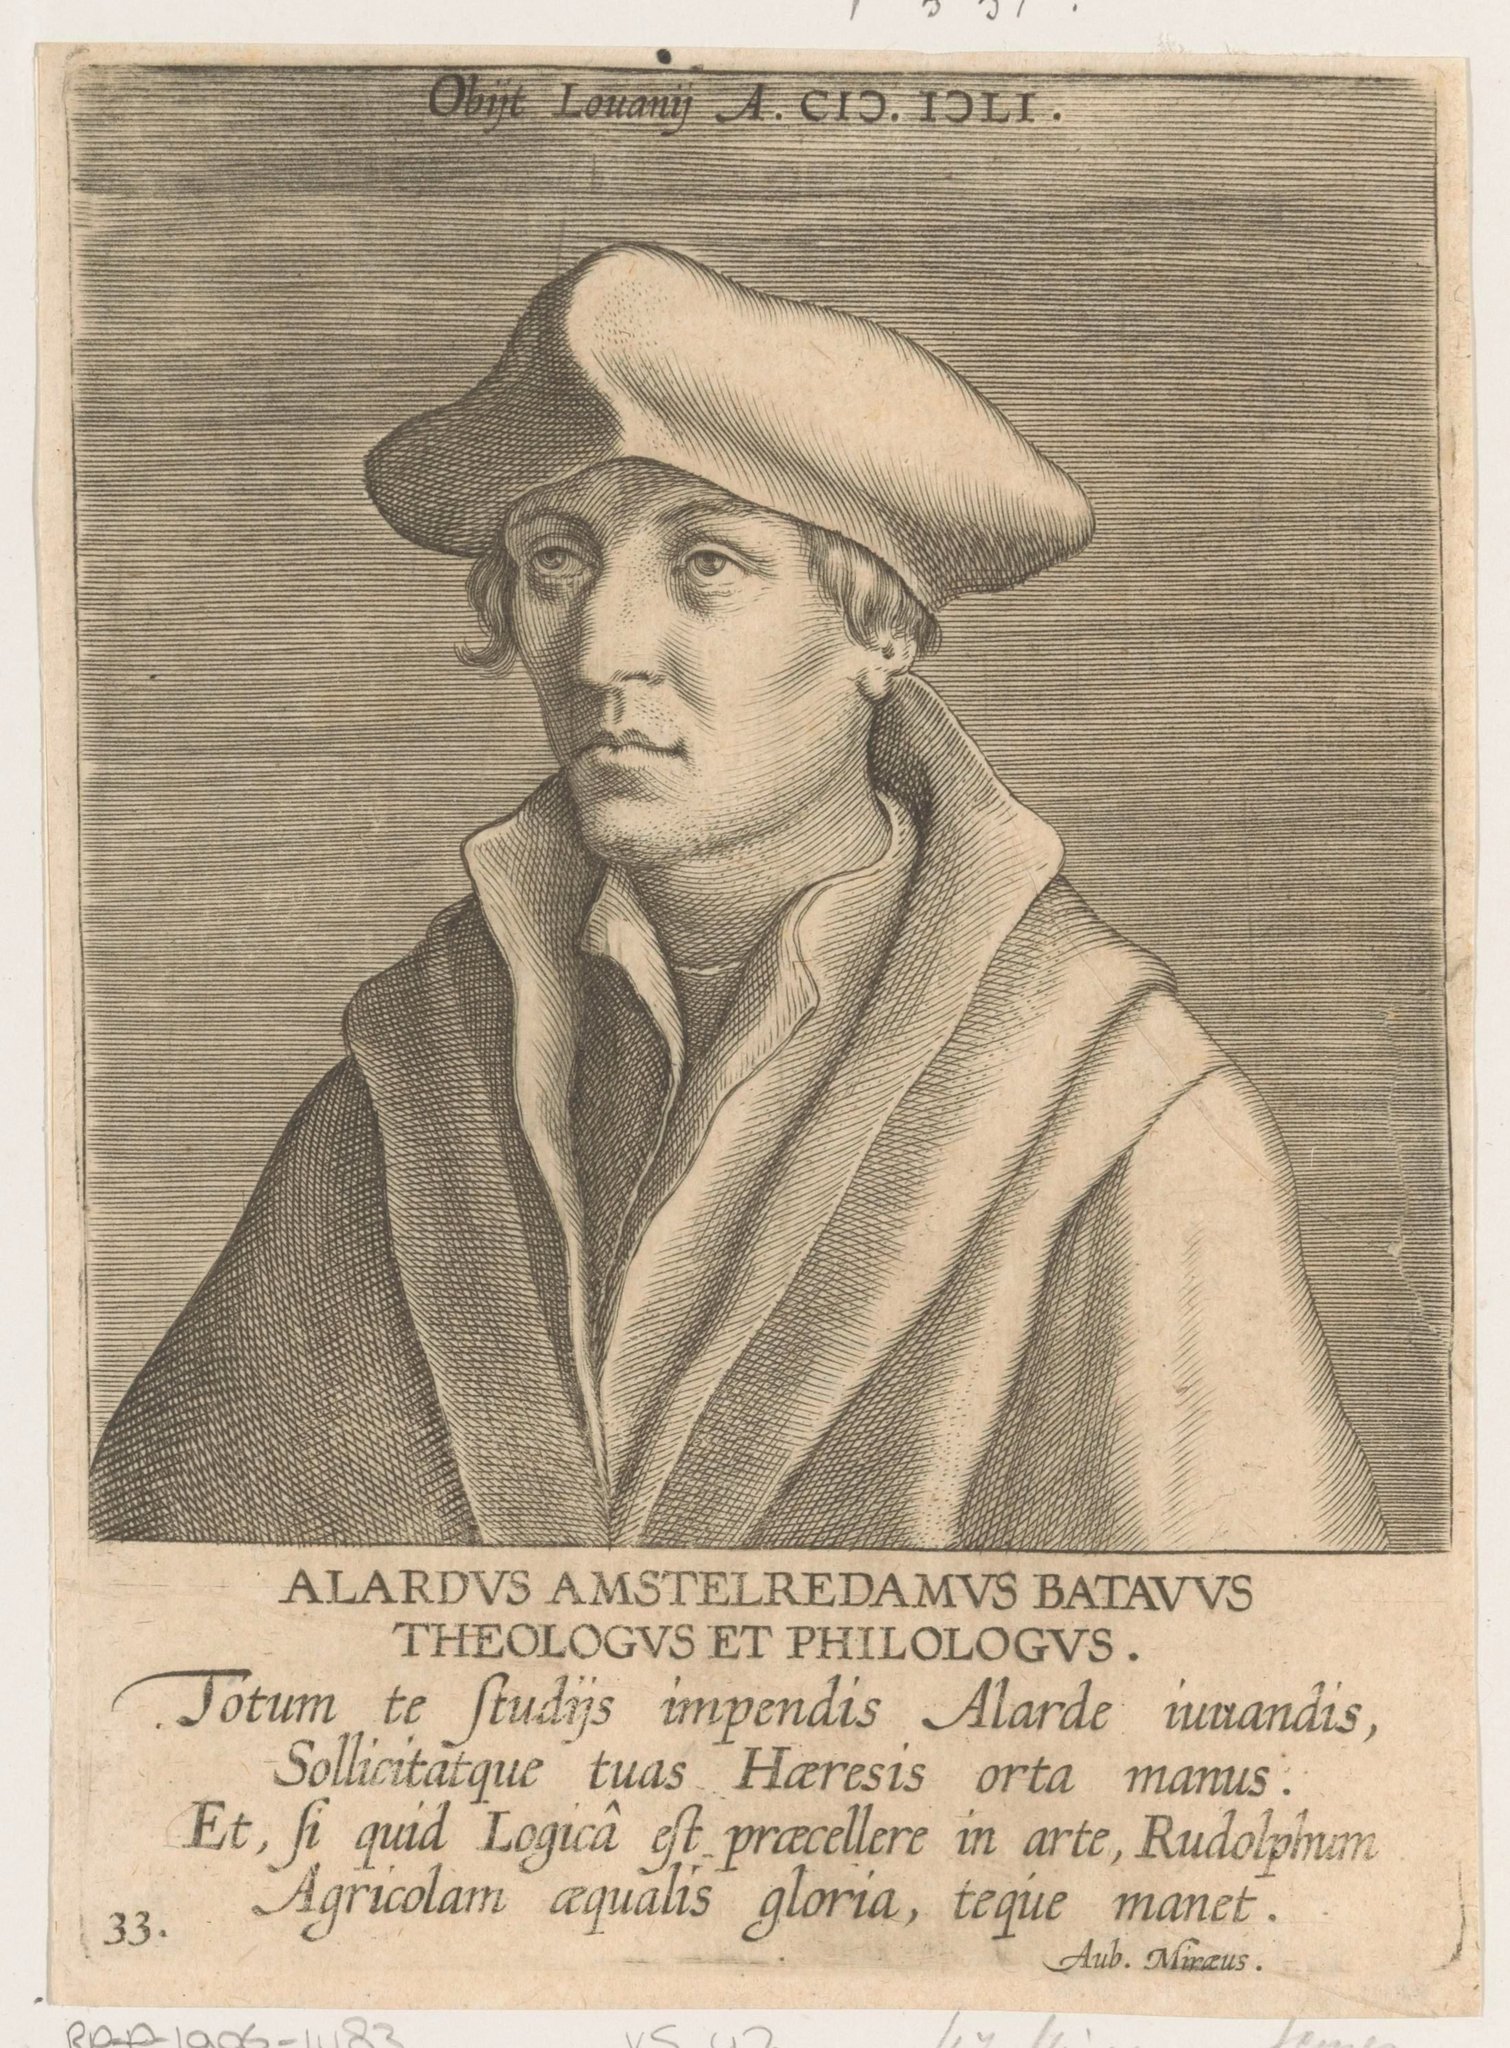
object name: book illustration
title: Portret van Allard van Amsterdam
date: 1604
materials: paper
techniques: engraving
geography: antwerp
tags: amsterdam, louvain, allard van amsterdam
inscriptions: collector's mark: Lugt 2228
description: Portret van Allard van Amsterdam. In de bovenmarge zijn sterfplaats en sterfjaar. In de ondermarge zijn naam, zijn beroepen en vier regels Latijnse tekst. Linksonder: 33.